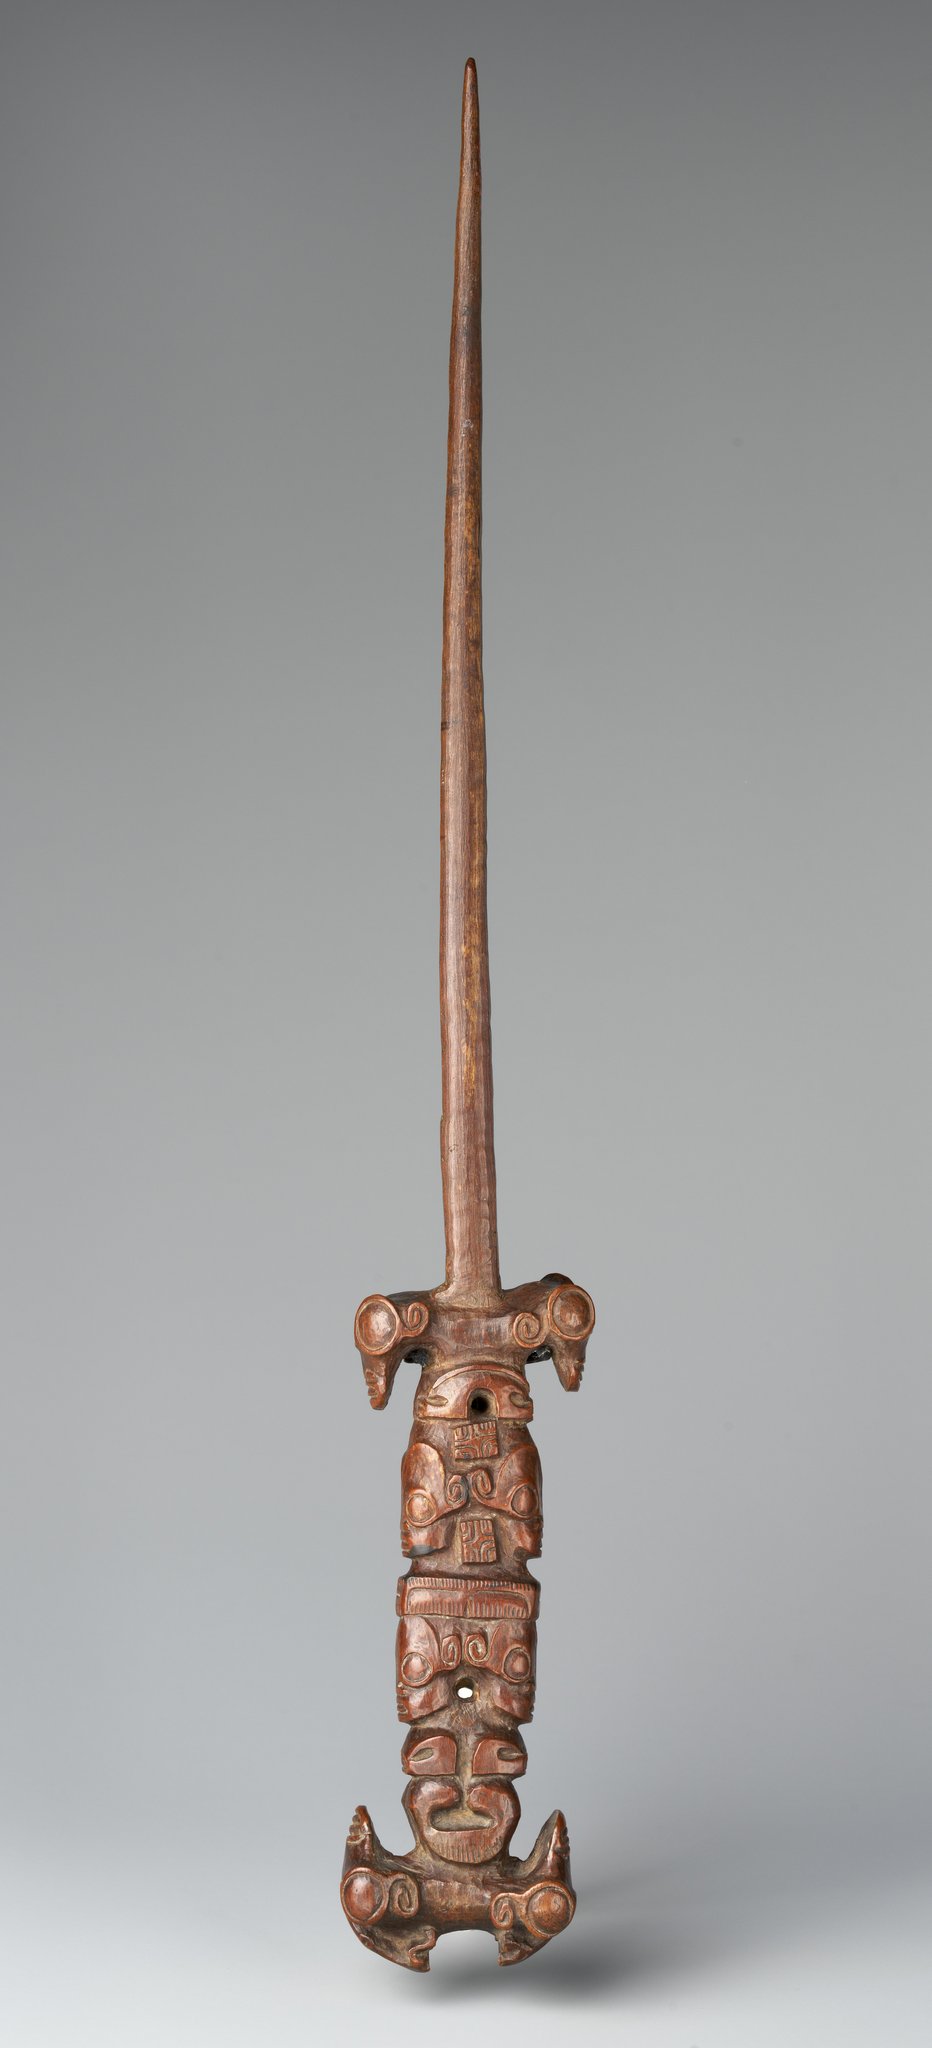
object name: fan handle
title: Fan Handle (Ke'e)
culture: marquesan, enata people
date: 1820-1850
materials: wood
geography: marquesas islands